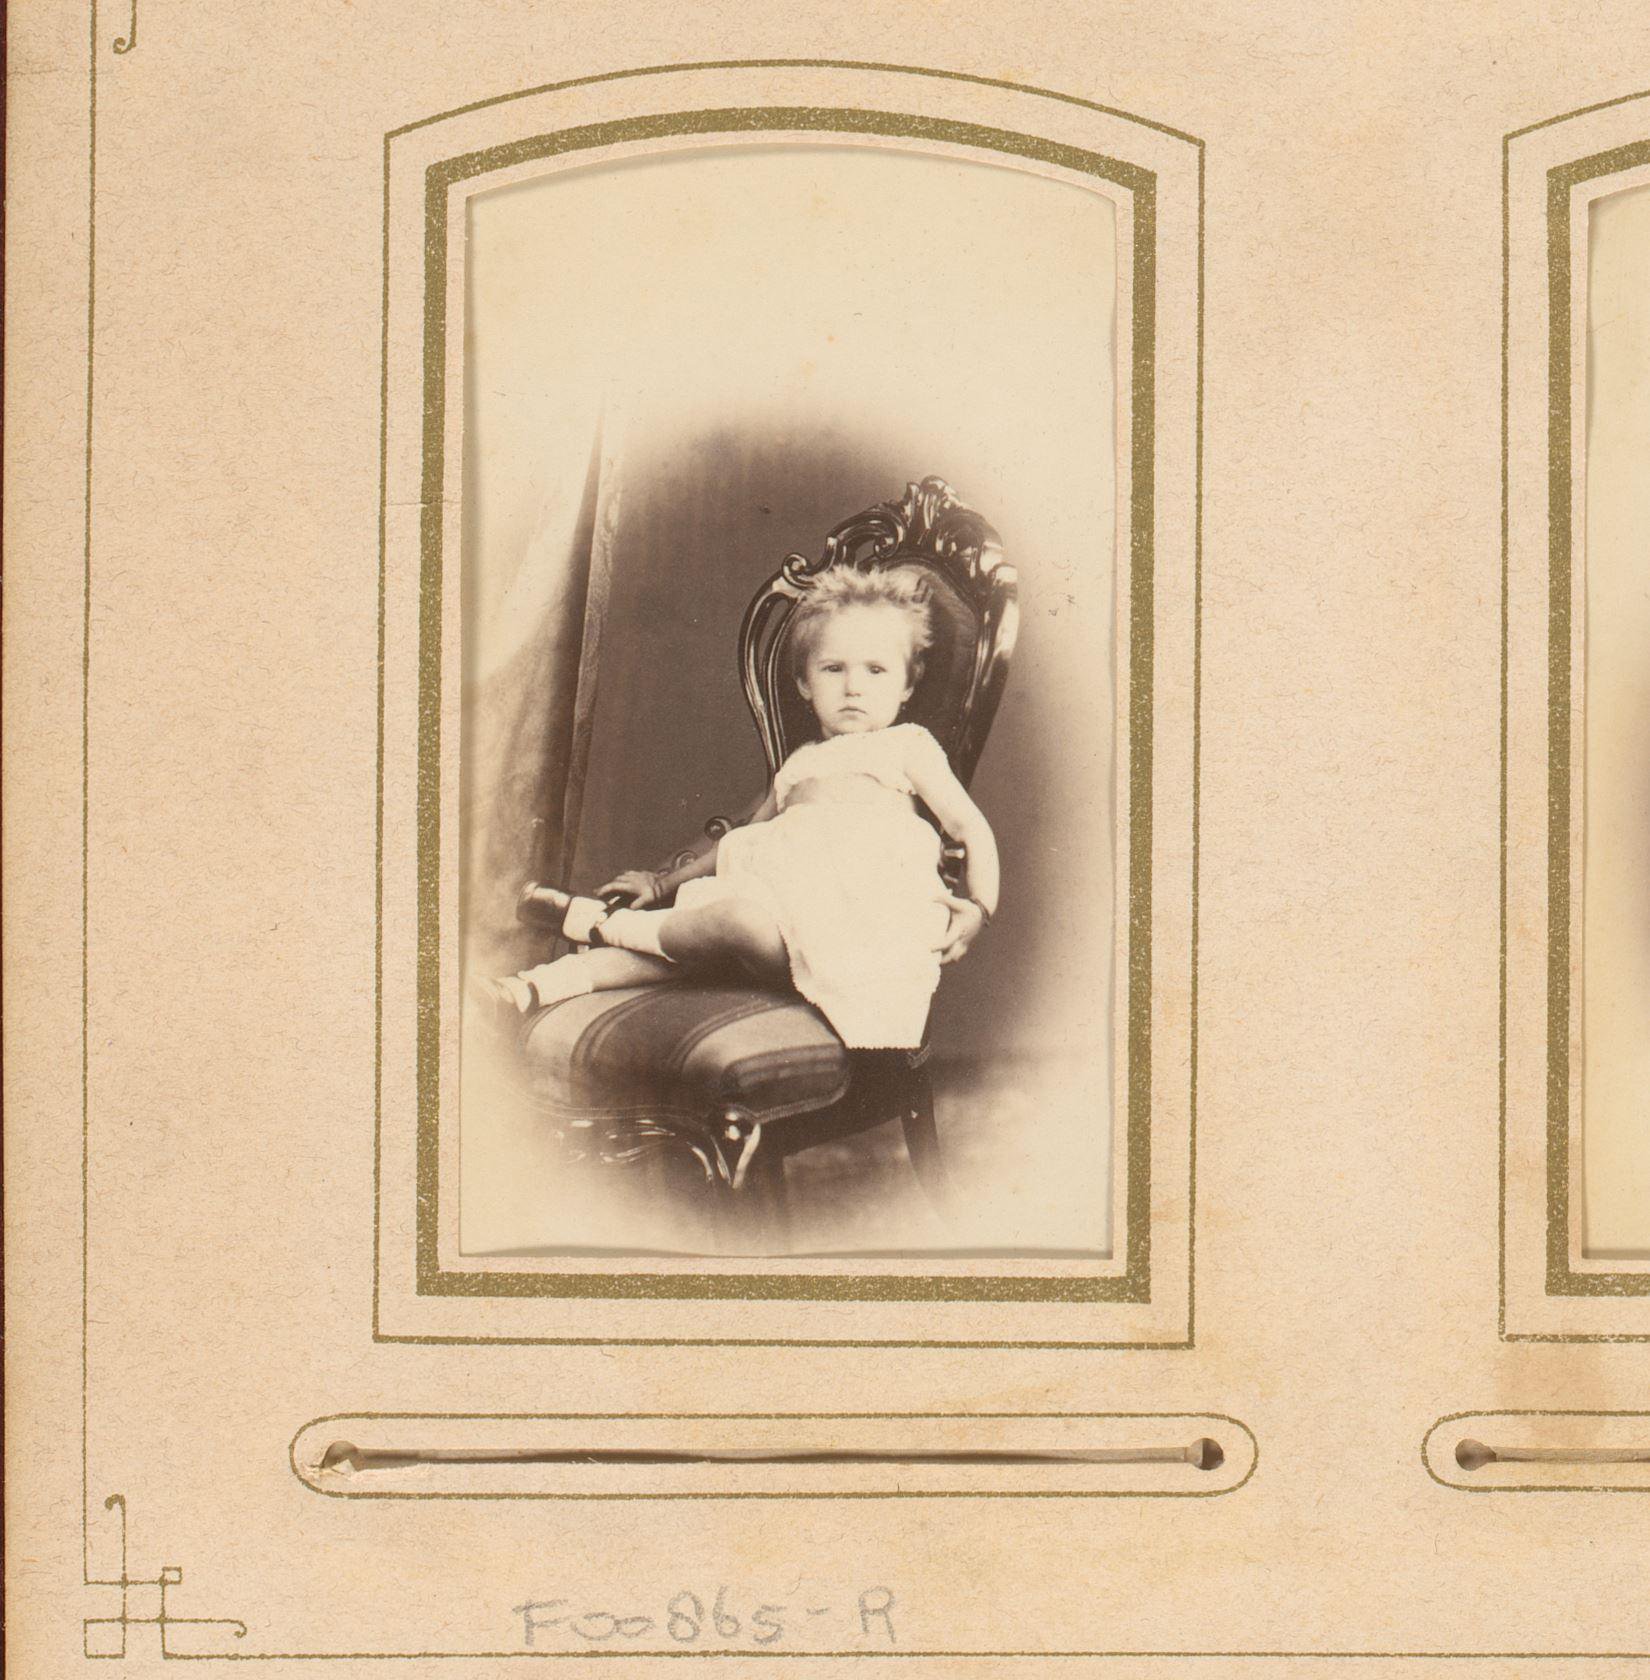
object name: album leaf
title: Portret van een zittende peuter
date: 1874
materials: cardboard, photographic support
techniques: albumen print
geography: batavia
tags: sitting figure, historical persons, tot, toddler ~ the ages of man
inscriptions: inscription: ‘Atelier/ Petz & Co./ JAVA/ Batavia./ Portretten in elke grootte & genre./ Nabestellingen worden zelfs na/ verloop van jaren geeffectueerd.’, date: ‘2 Maart 1874’